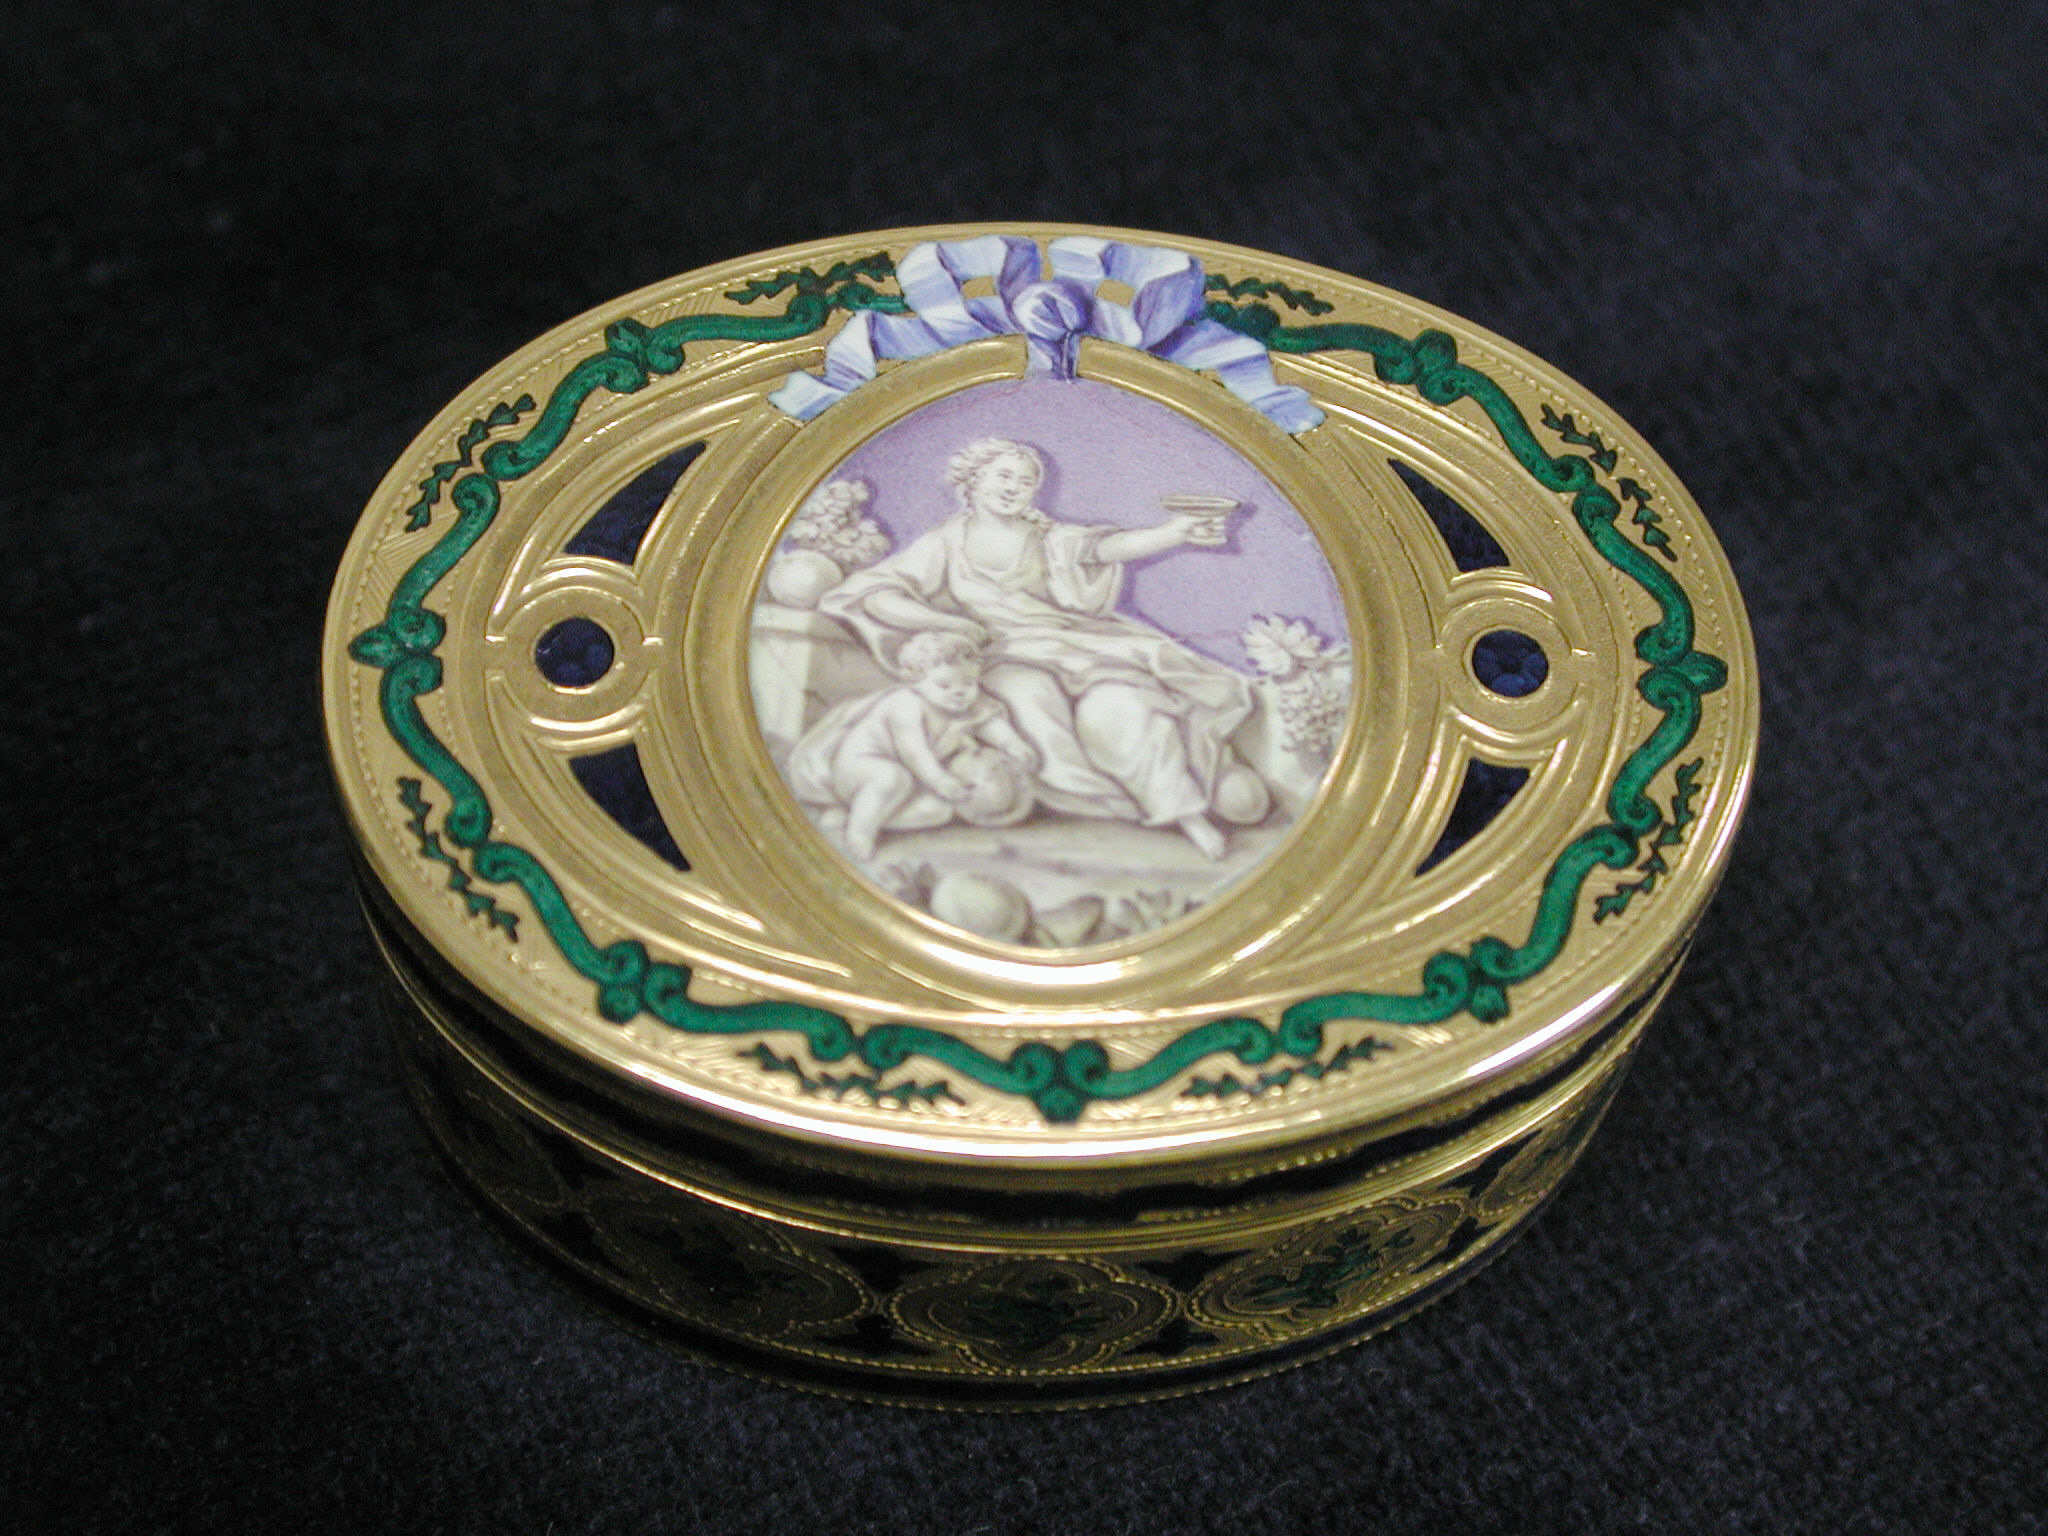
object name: snuffbox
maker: pierre médard mothet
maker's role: maker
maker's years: 1761-1791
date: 1765-1766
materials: enamel, gold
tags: children,women